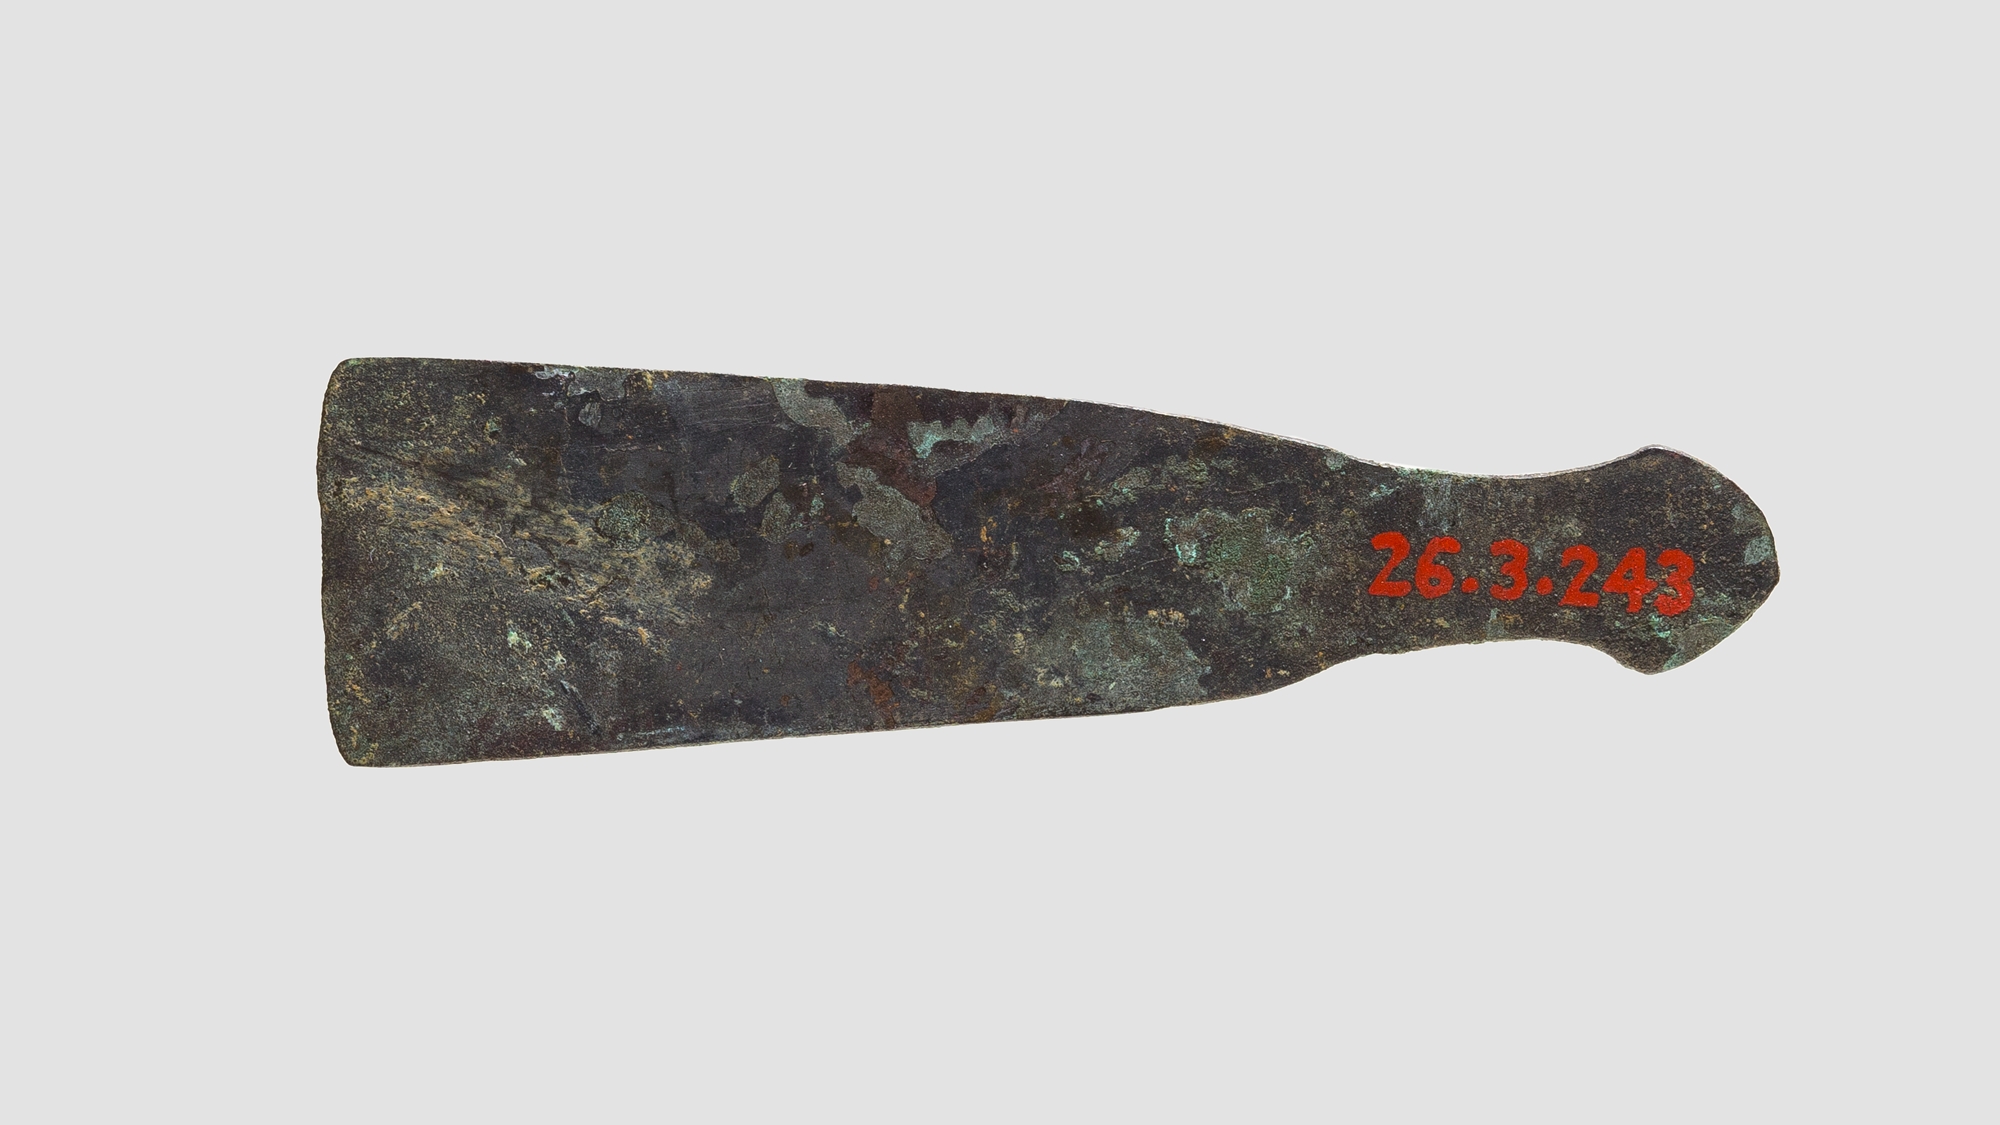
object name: model adze blade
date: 2030-1640 BCE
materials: bronze, copper alloy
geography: egypt